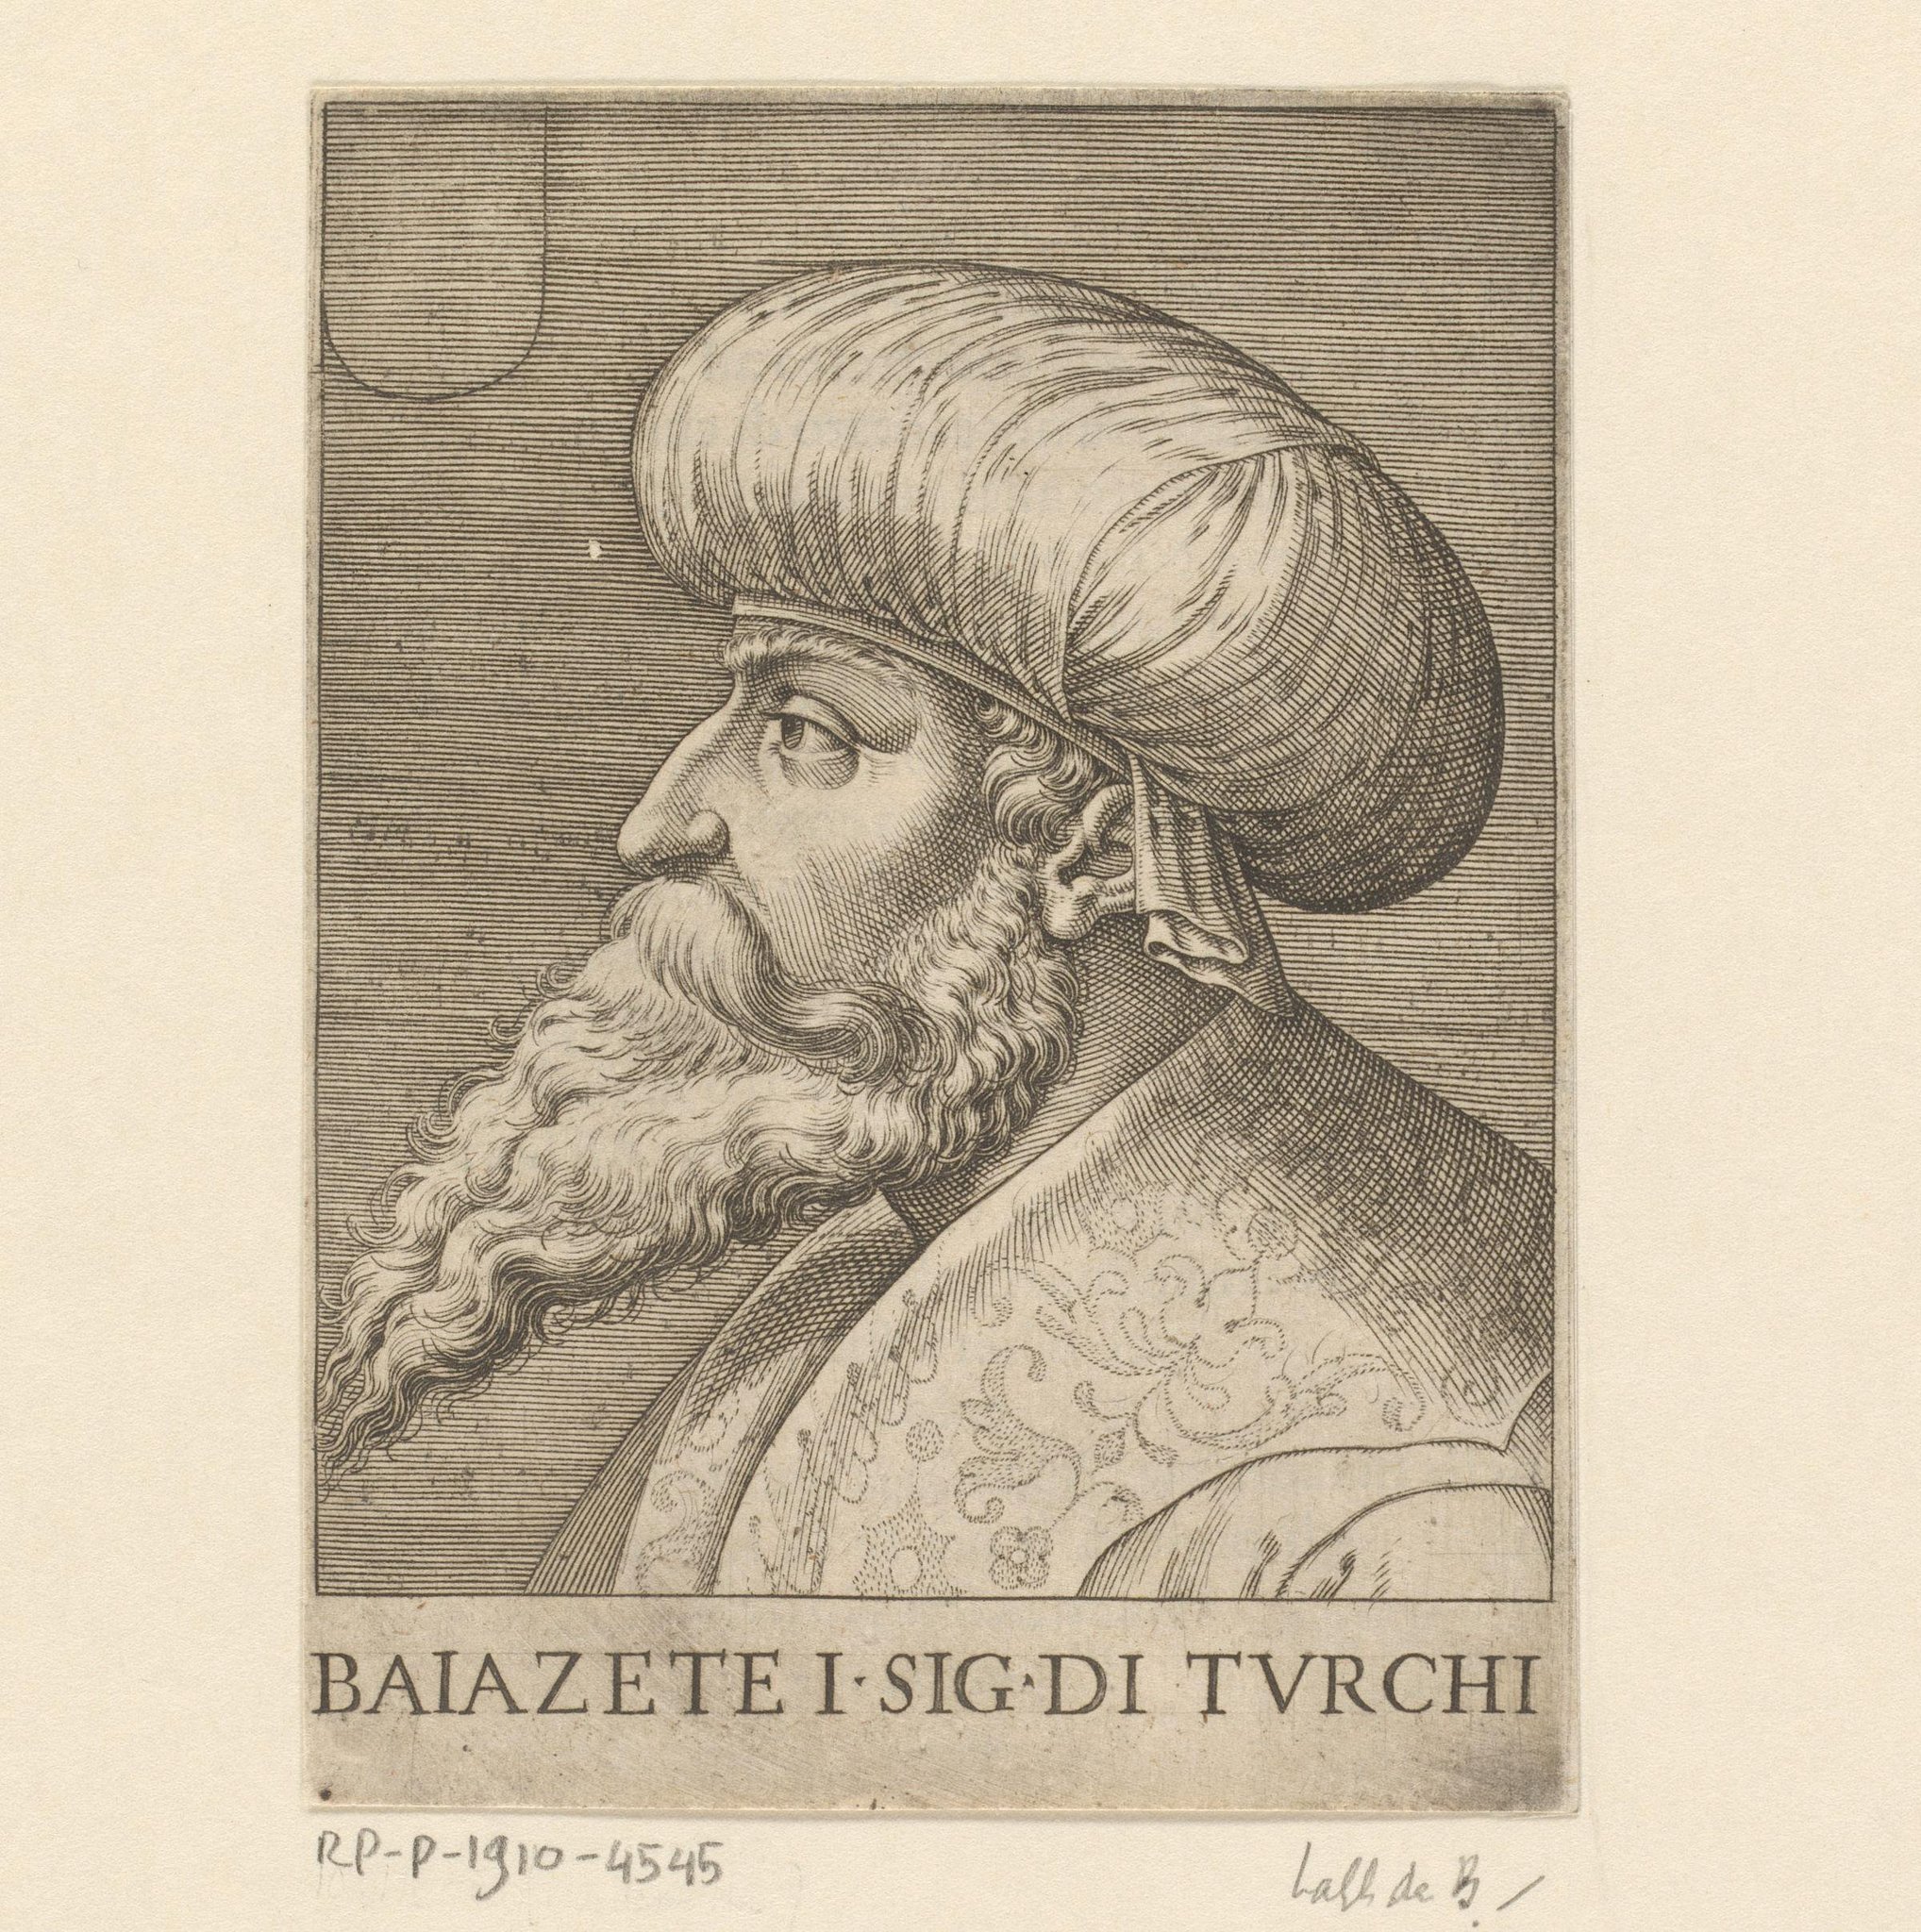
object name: book illustration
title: Portret van Bayezid I, sultan van het Ottomaanse Rijk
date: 1596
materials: paper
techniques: engraving, letterpress printing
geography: rome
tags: historical persons, ruler, sovereign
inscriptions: collector's mark: Lugt 2228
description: Prent uit: Ritratti di cento capitani illustri con li lor Fatti in guerra (…), Rome: Domenico Gigliotti, 1596. Latere staten van prent ook gebruikt in: Ritratti et elogii di capitani Illustri. Rome: Pompilio Totti en Andrea Fei, 1635. En in: Ritratti et elogii di capitani Illustri. Che ne'secoli moderni hanno gloriosamente guerreggiato. Rome: Filippo de'Rossi en Vitale Mascardi, 1646.